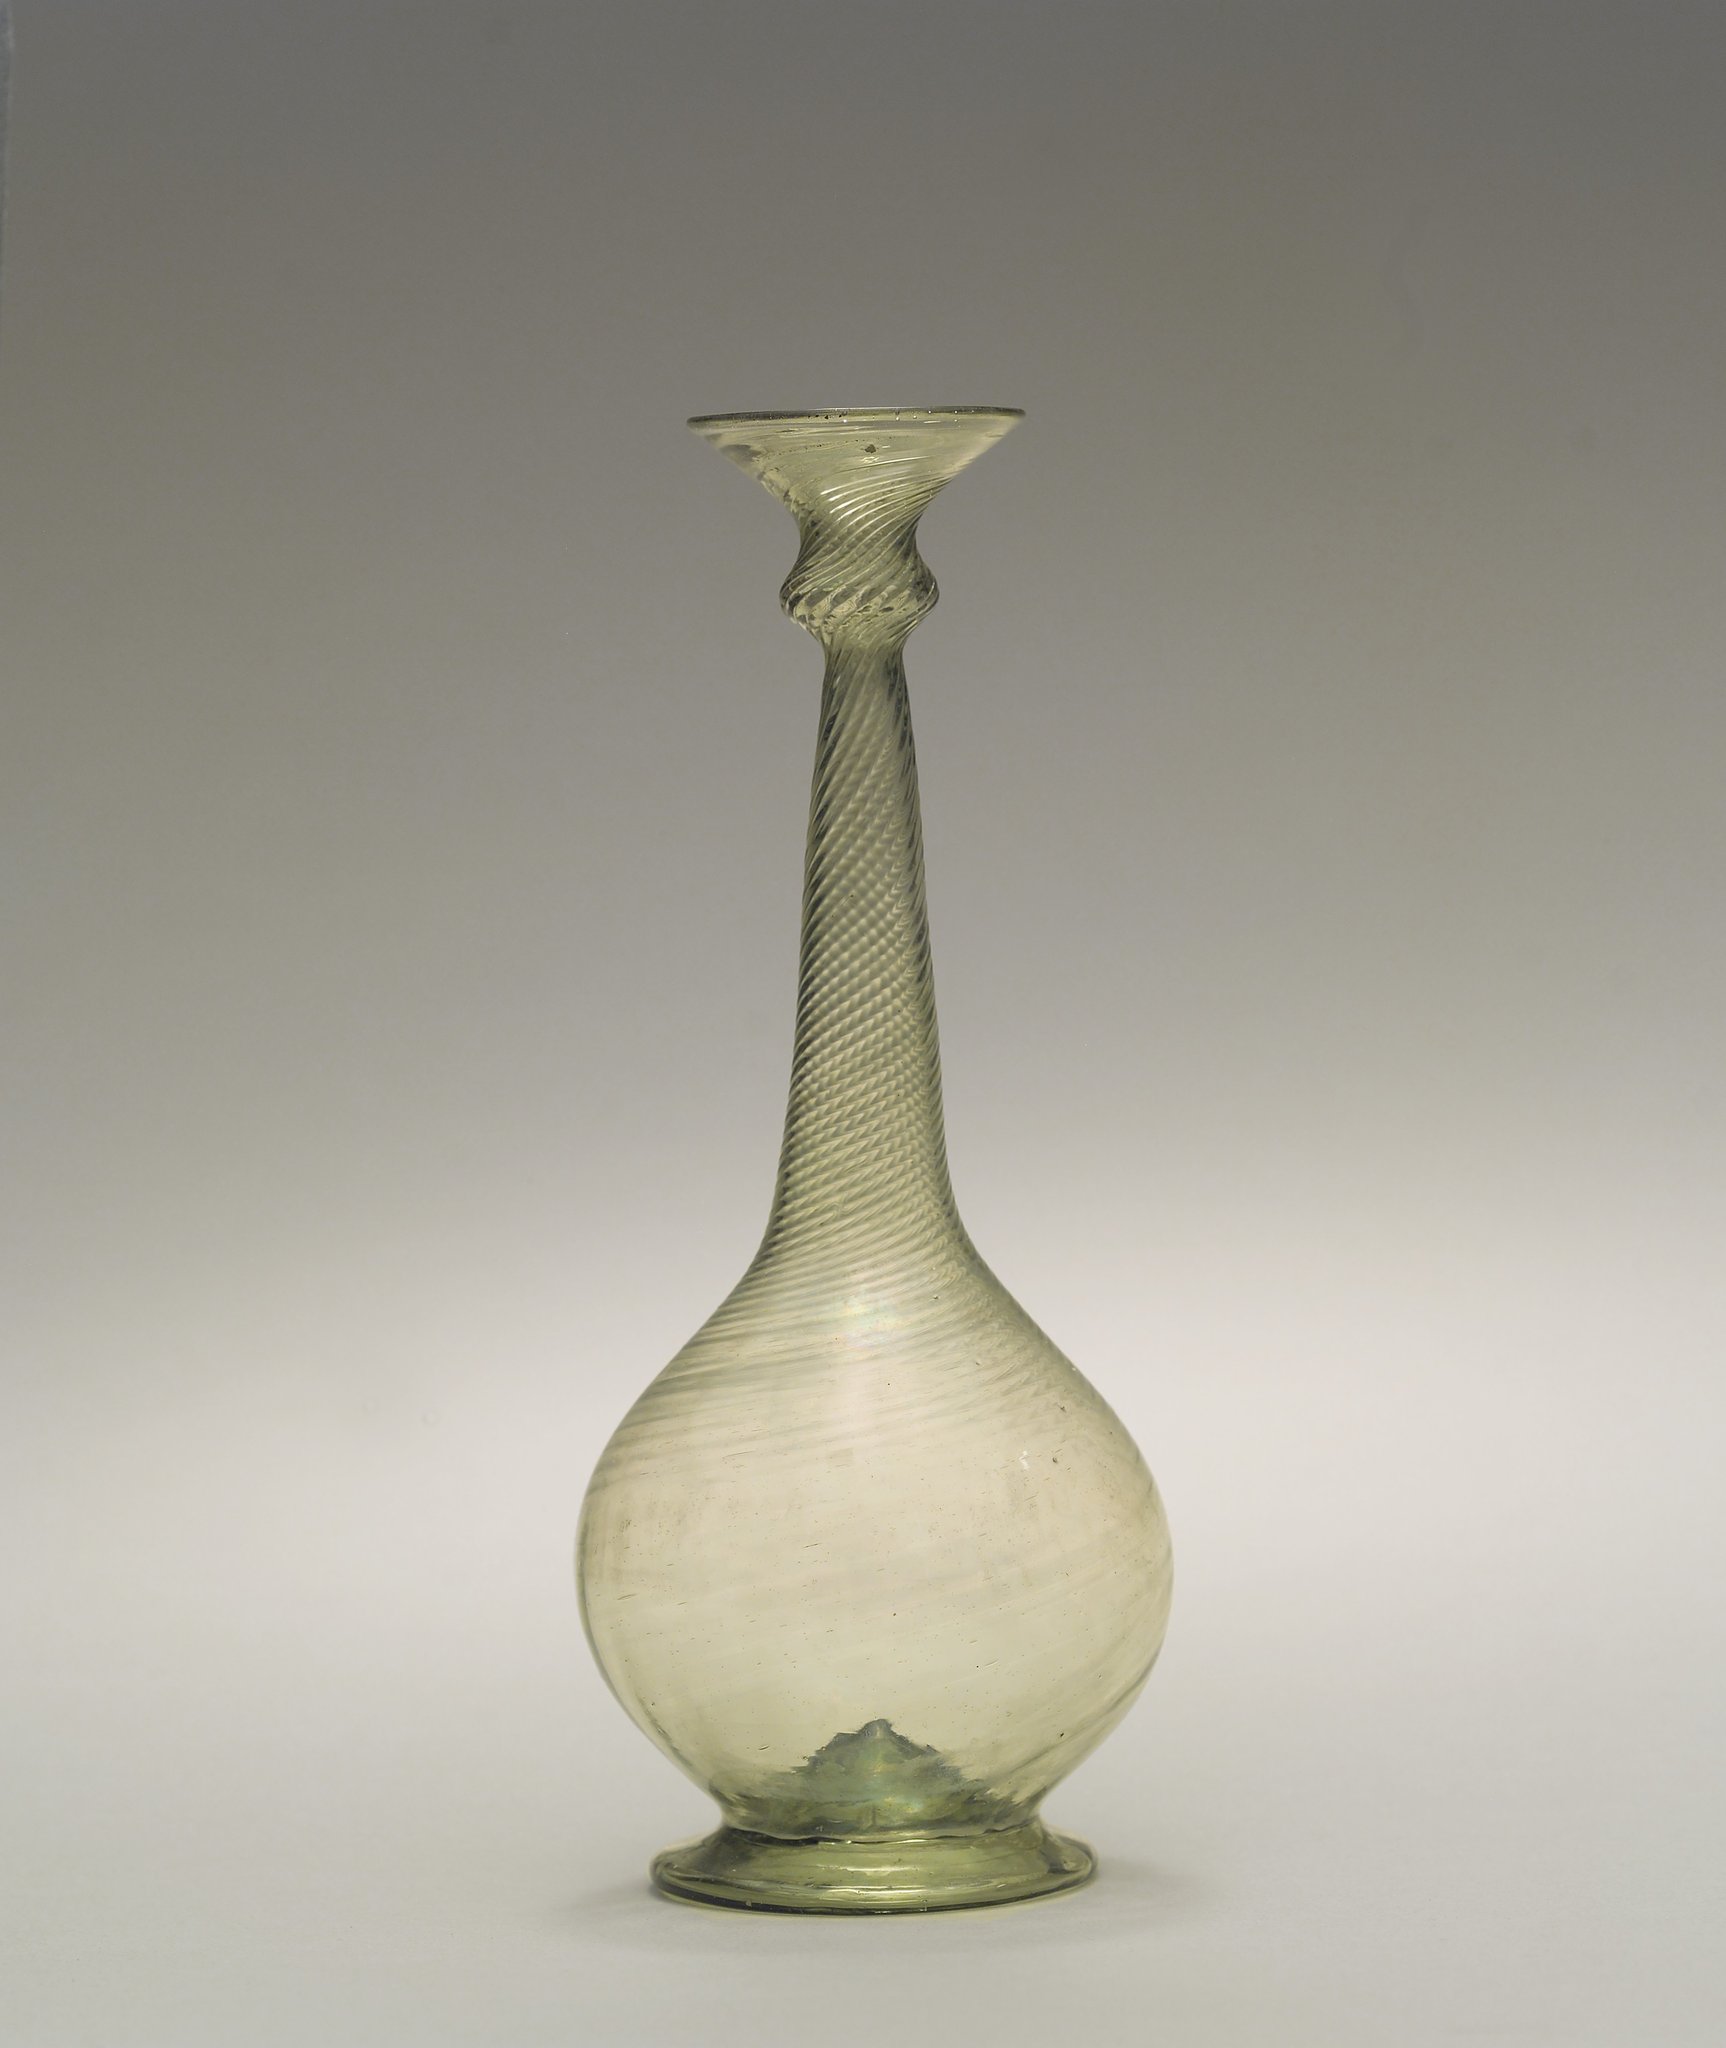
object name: bottle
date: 1701-1900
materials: glass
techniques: molding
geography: iran